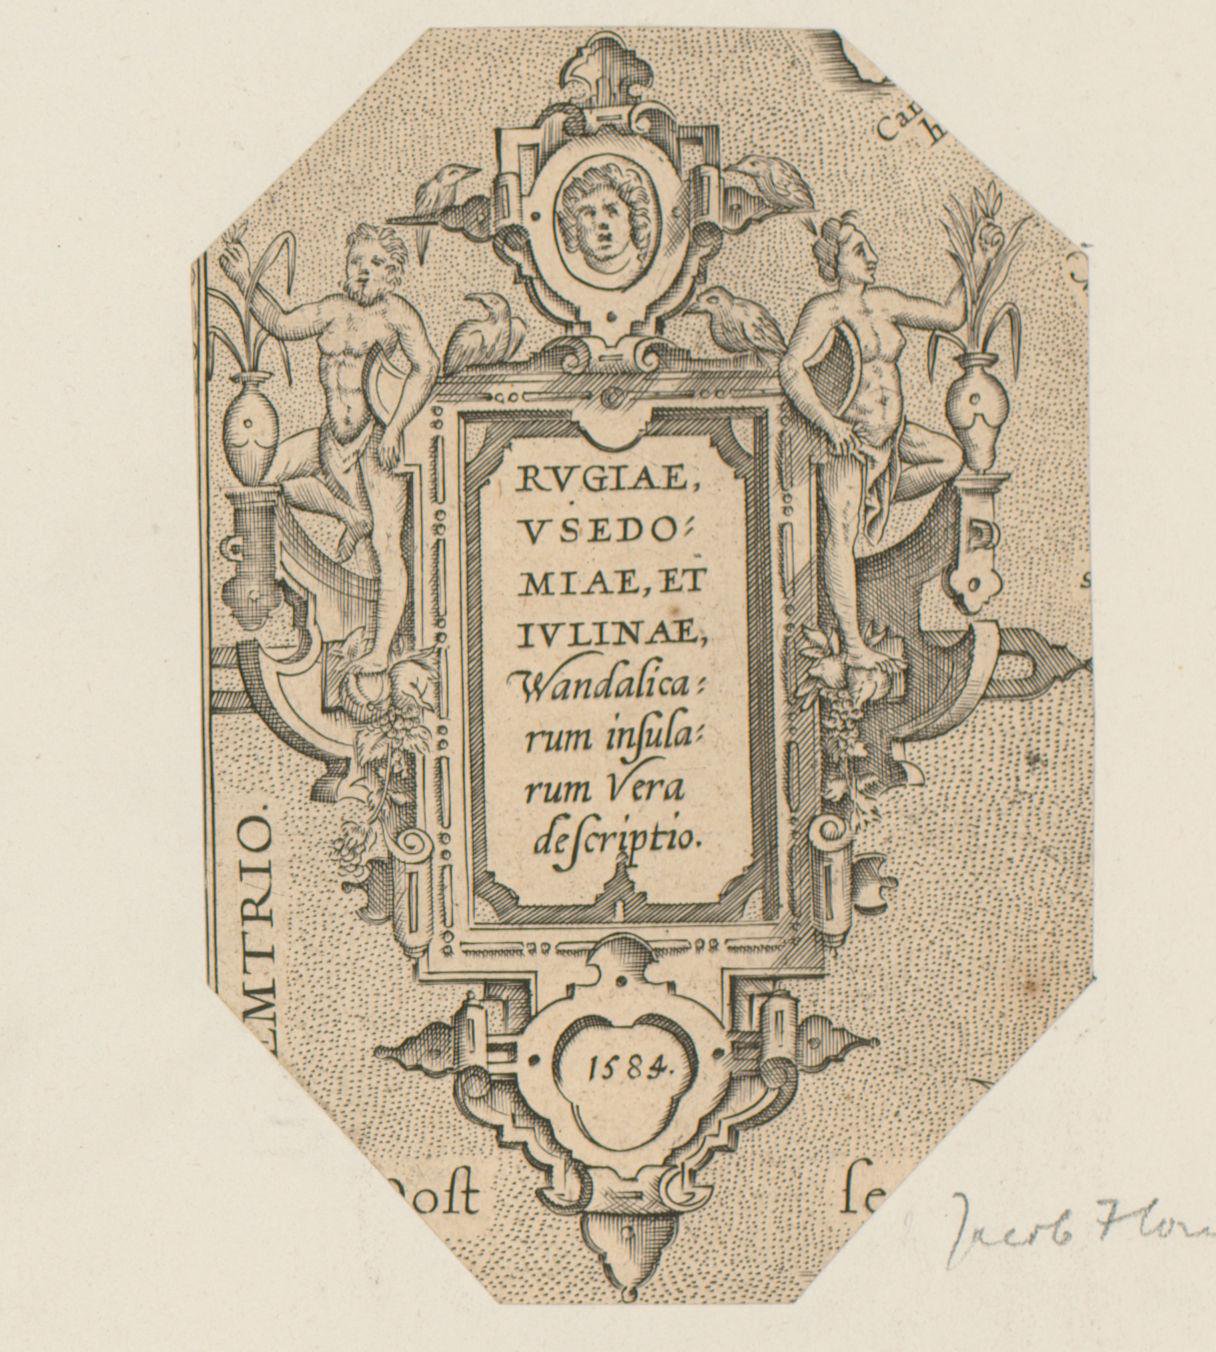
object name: ornament print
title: Cartouche van een kaart van Rügen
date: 1584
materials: paper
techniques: engraving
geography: antwerp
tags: standing figure, scrollwork, strapwork ~ ornament, birds, vase ~ ornament, ornament ~ cartouche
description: Rechthoekige staande cartouche geflankeerd door twee staande manfiguren bij een vaas. De cartouche is een fragment van een kaart van Rügen. De prent maakt deel uit van een album.